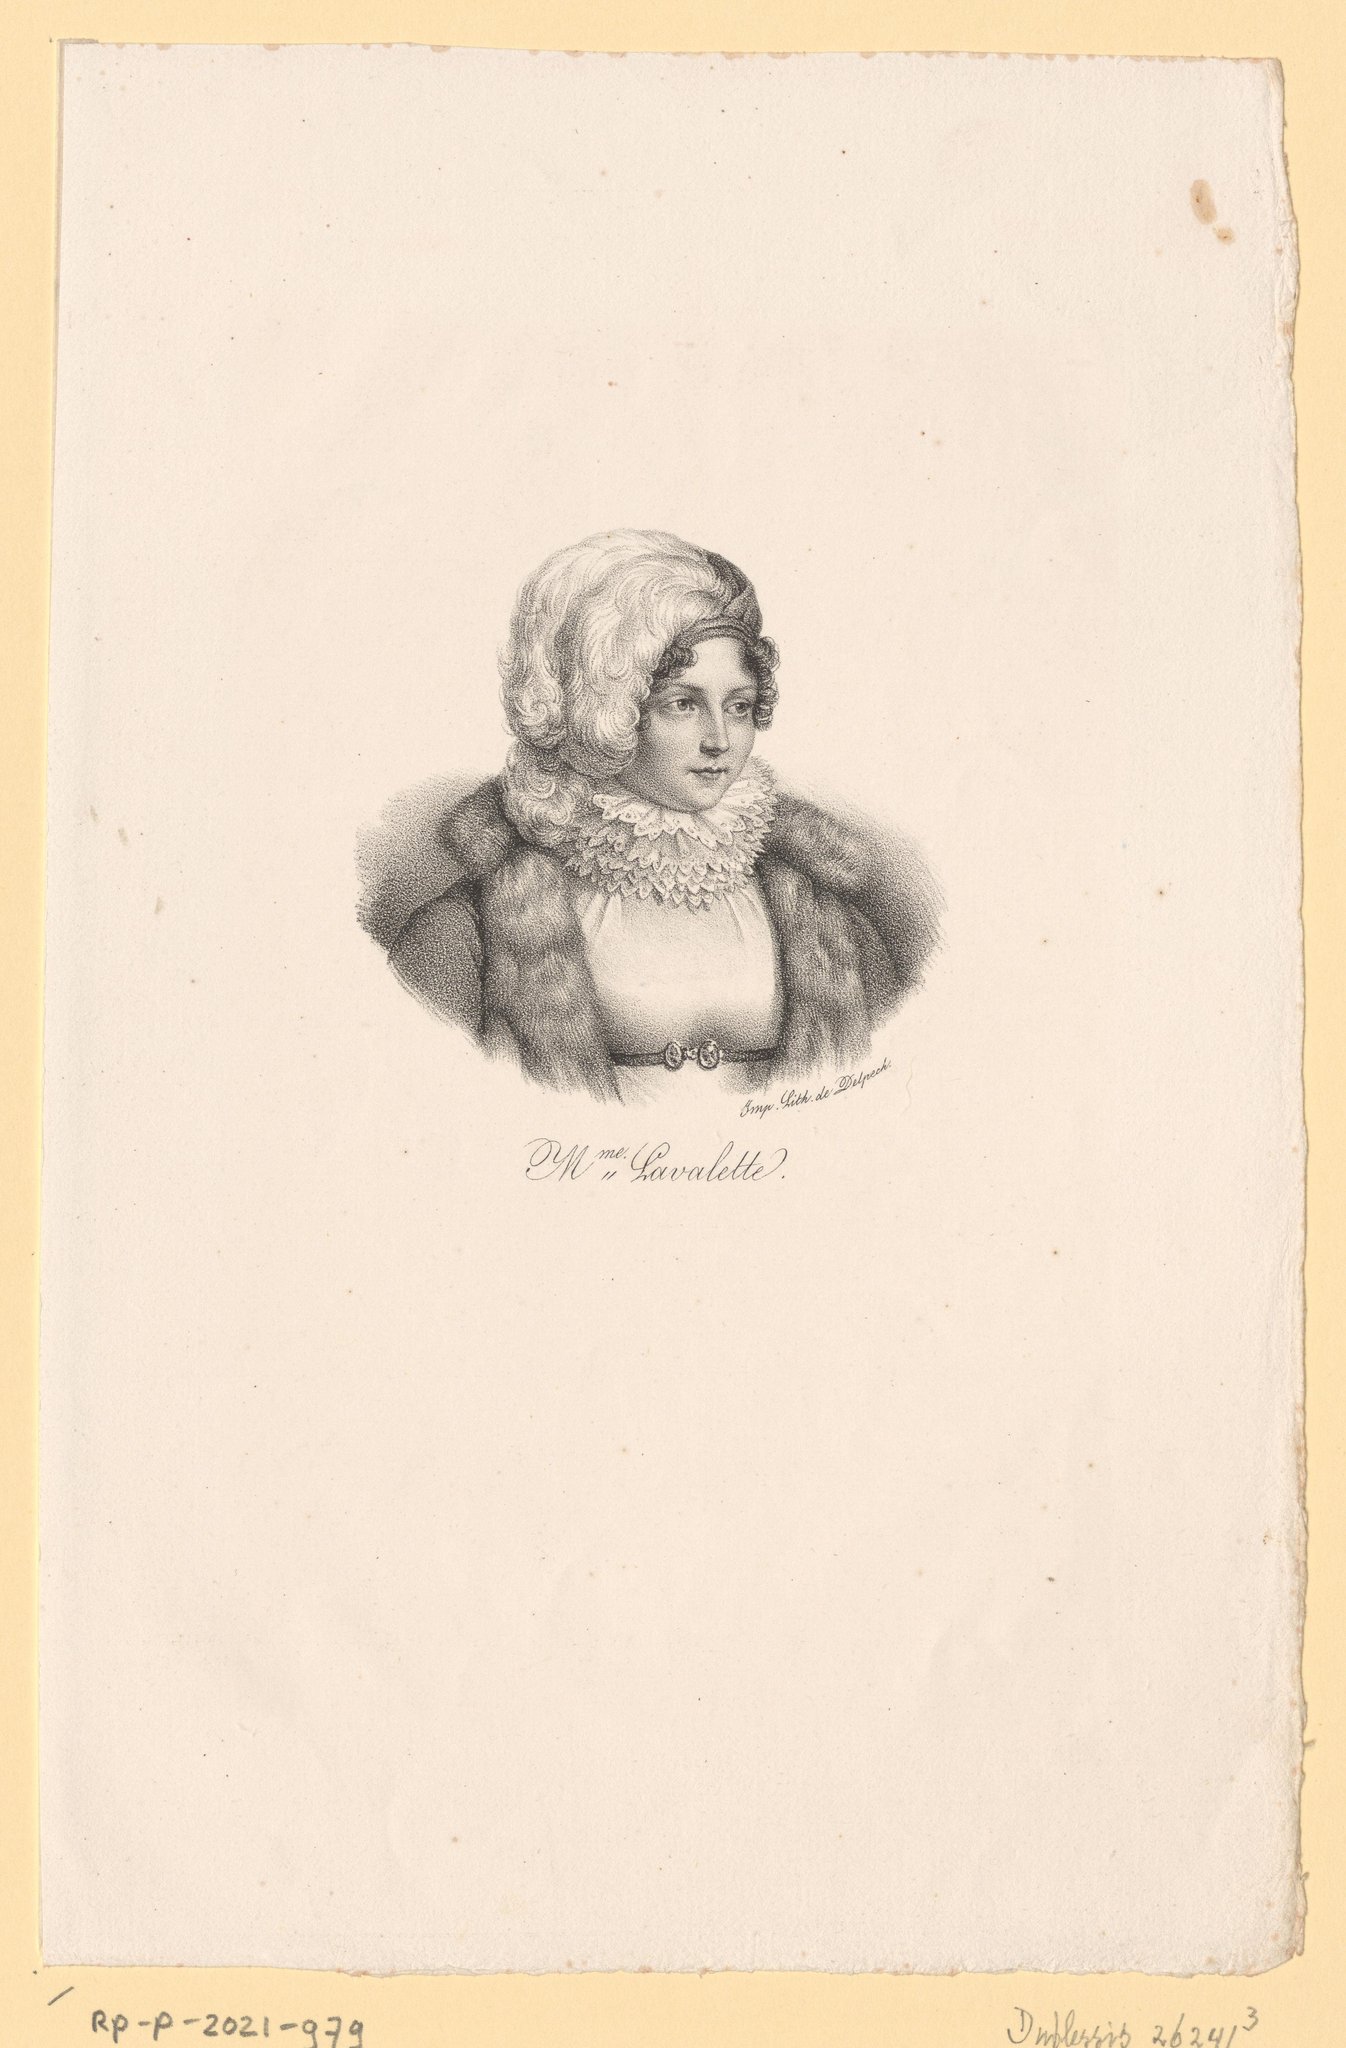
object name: print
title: Portret van Emilie Louise de Beauharnais, gravin van Lavalette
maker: Anonymous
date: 1818-1842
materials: paper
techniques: lithograph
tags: historical persons - bb - woman